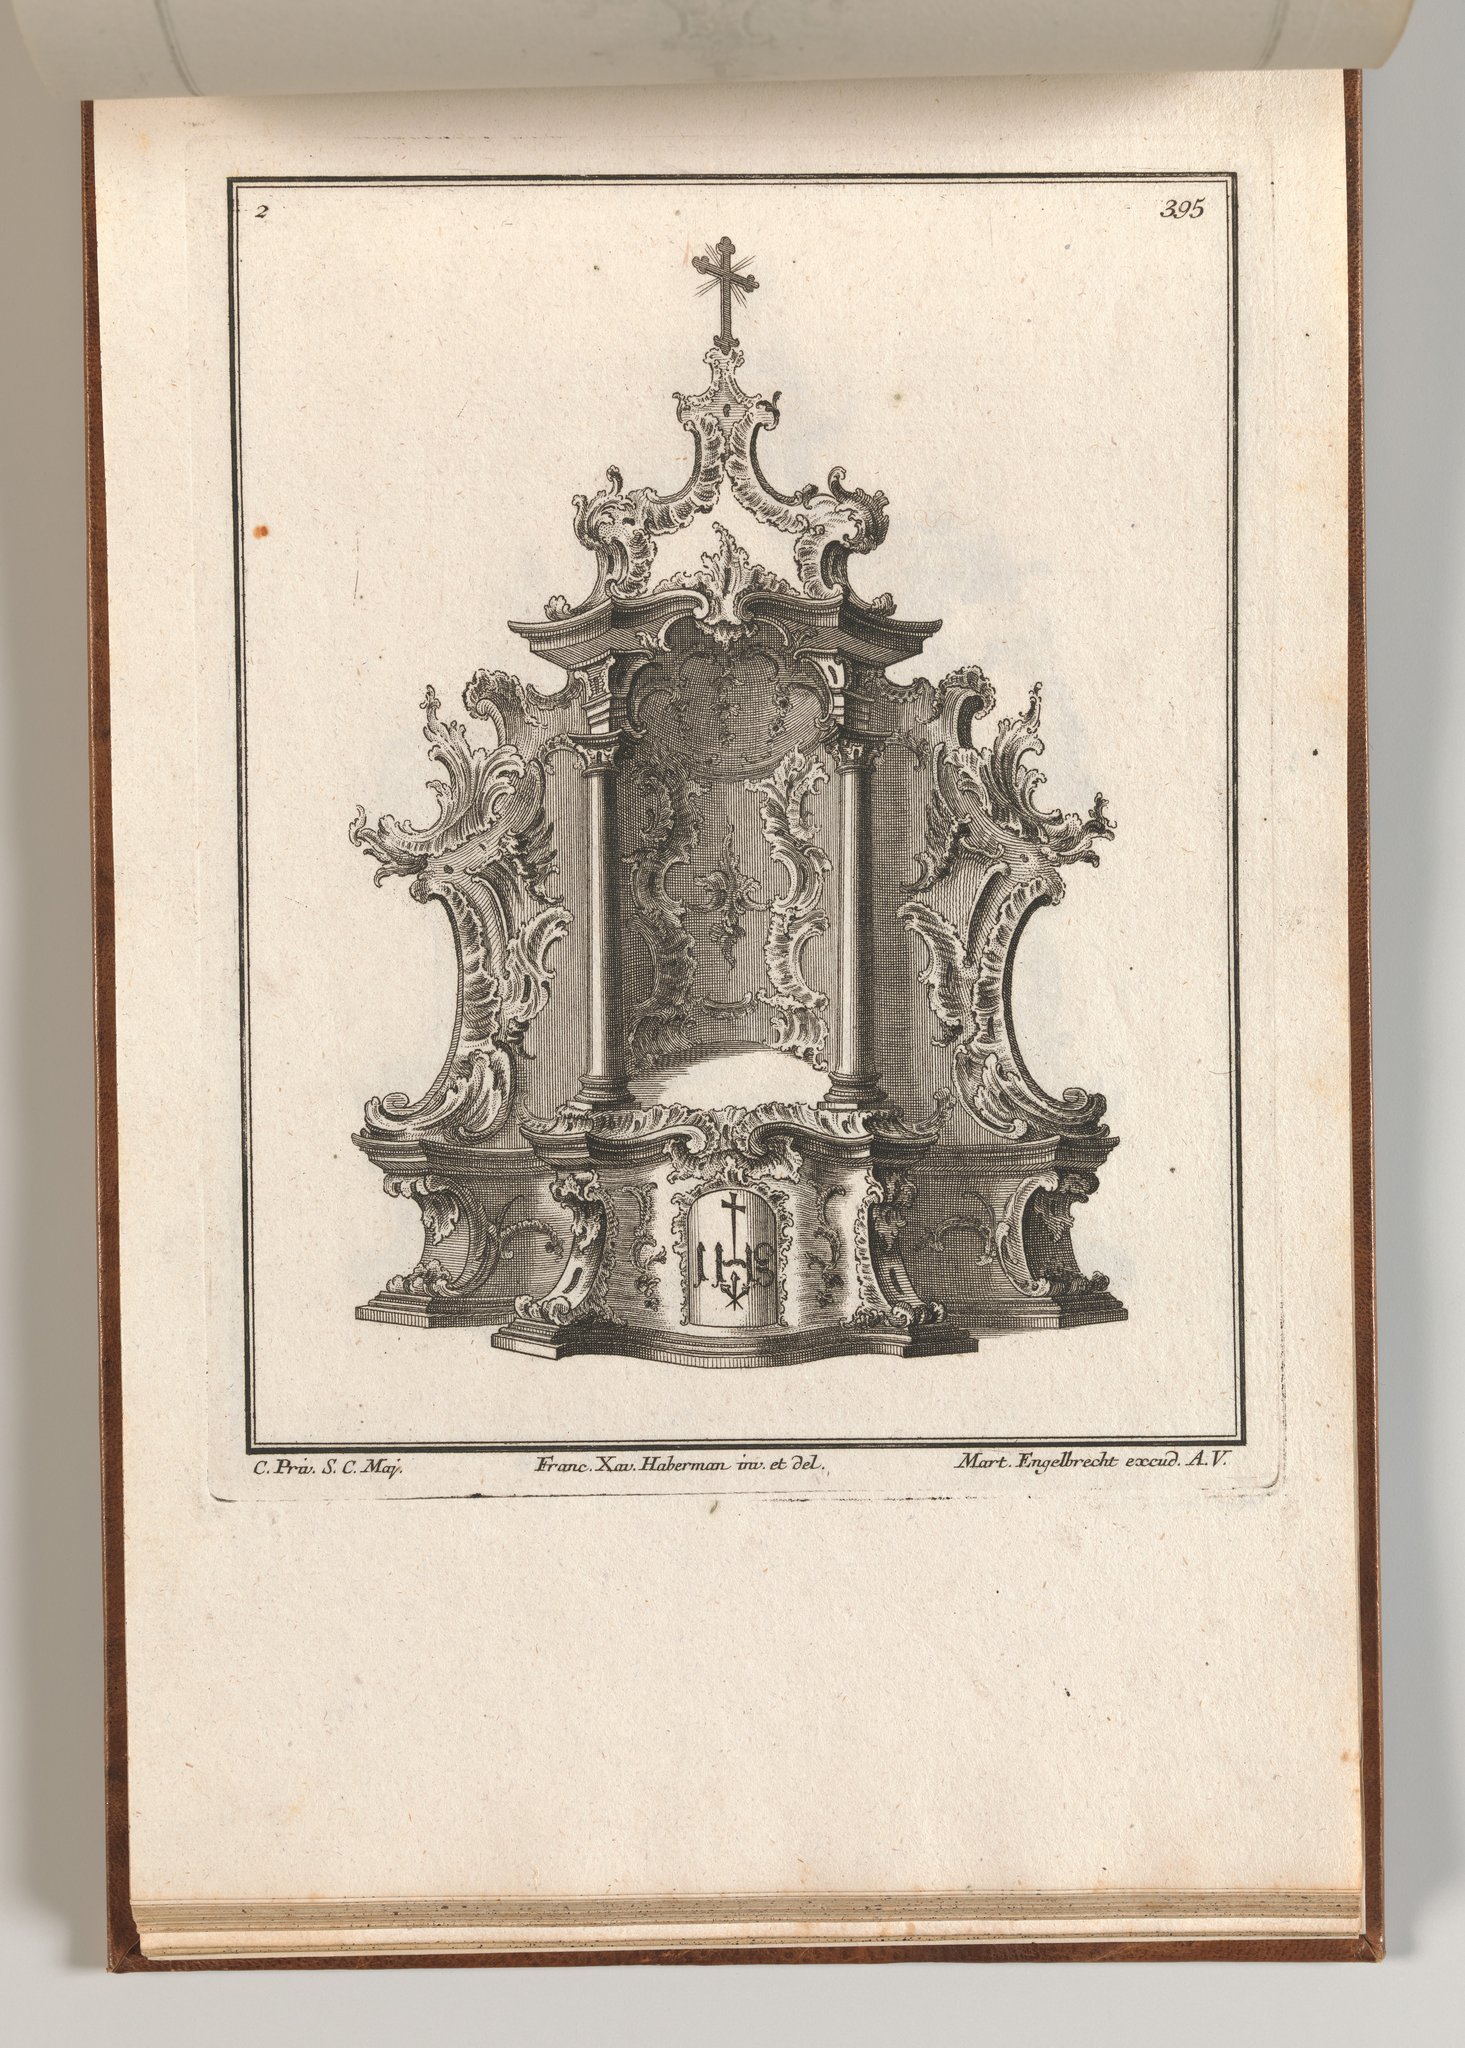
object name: album print ornament architecture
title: Design for a Tabernacle, Plate 2 from the series 'Tabernacle'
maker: franz xavier habermann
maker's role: artist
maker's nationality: german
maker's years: 1721-1796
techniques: etching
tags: tabernacles,cross